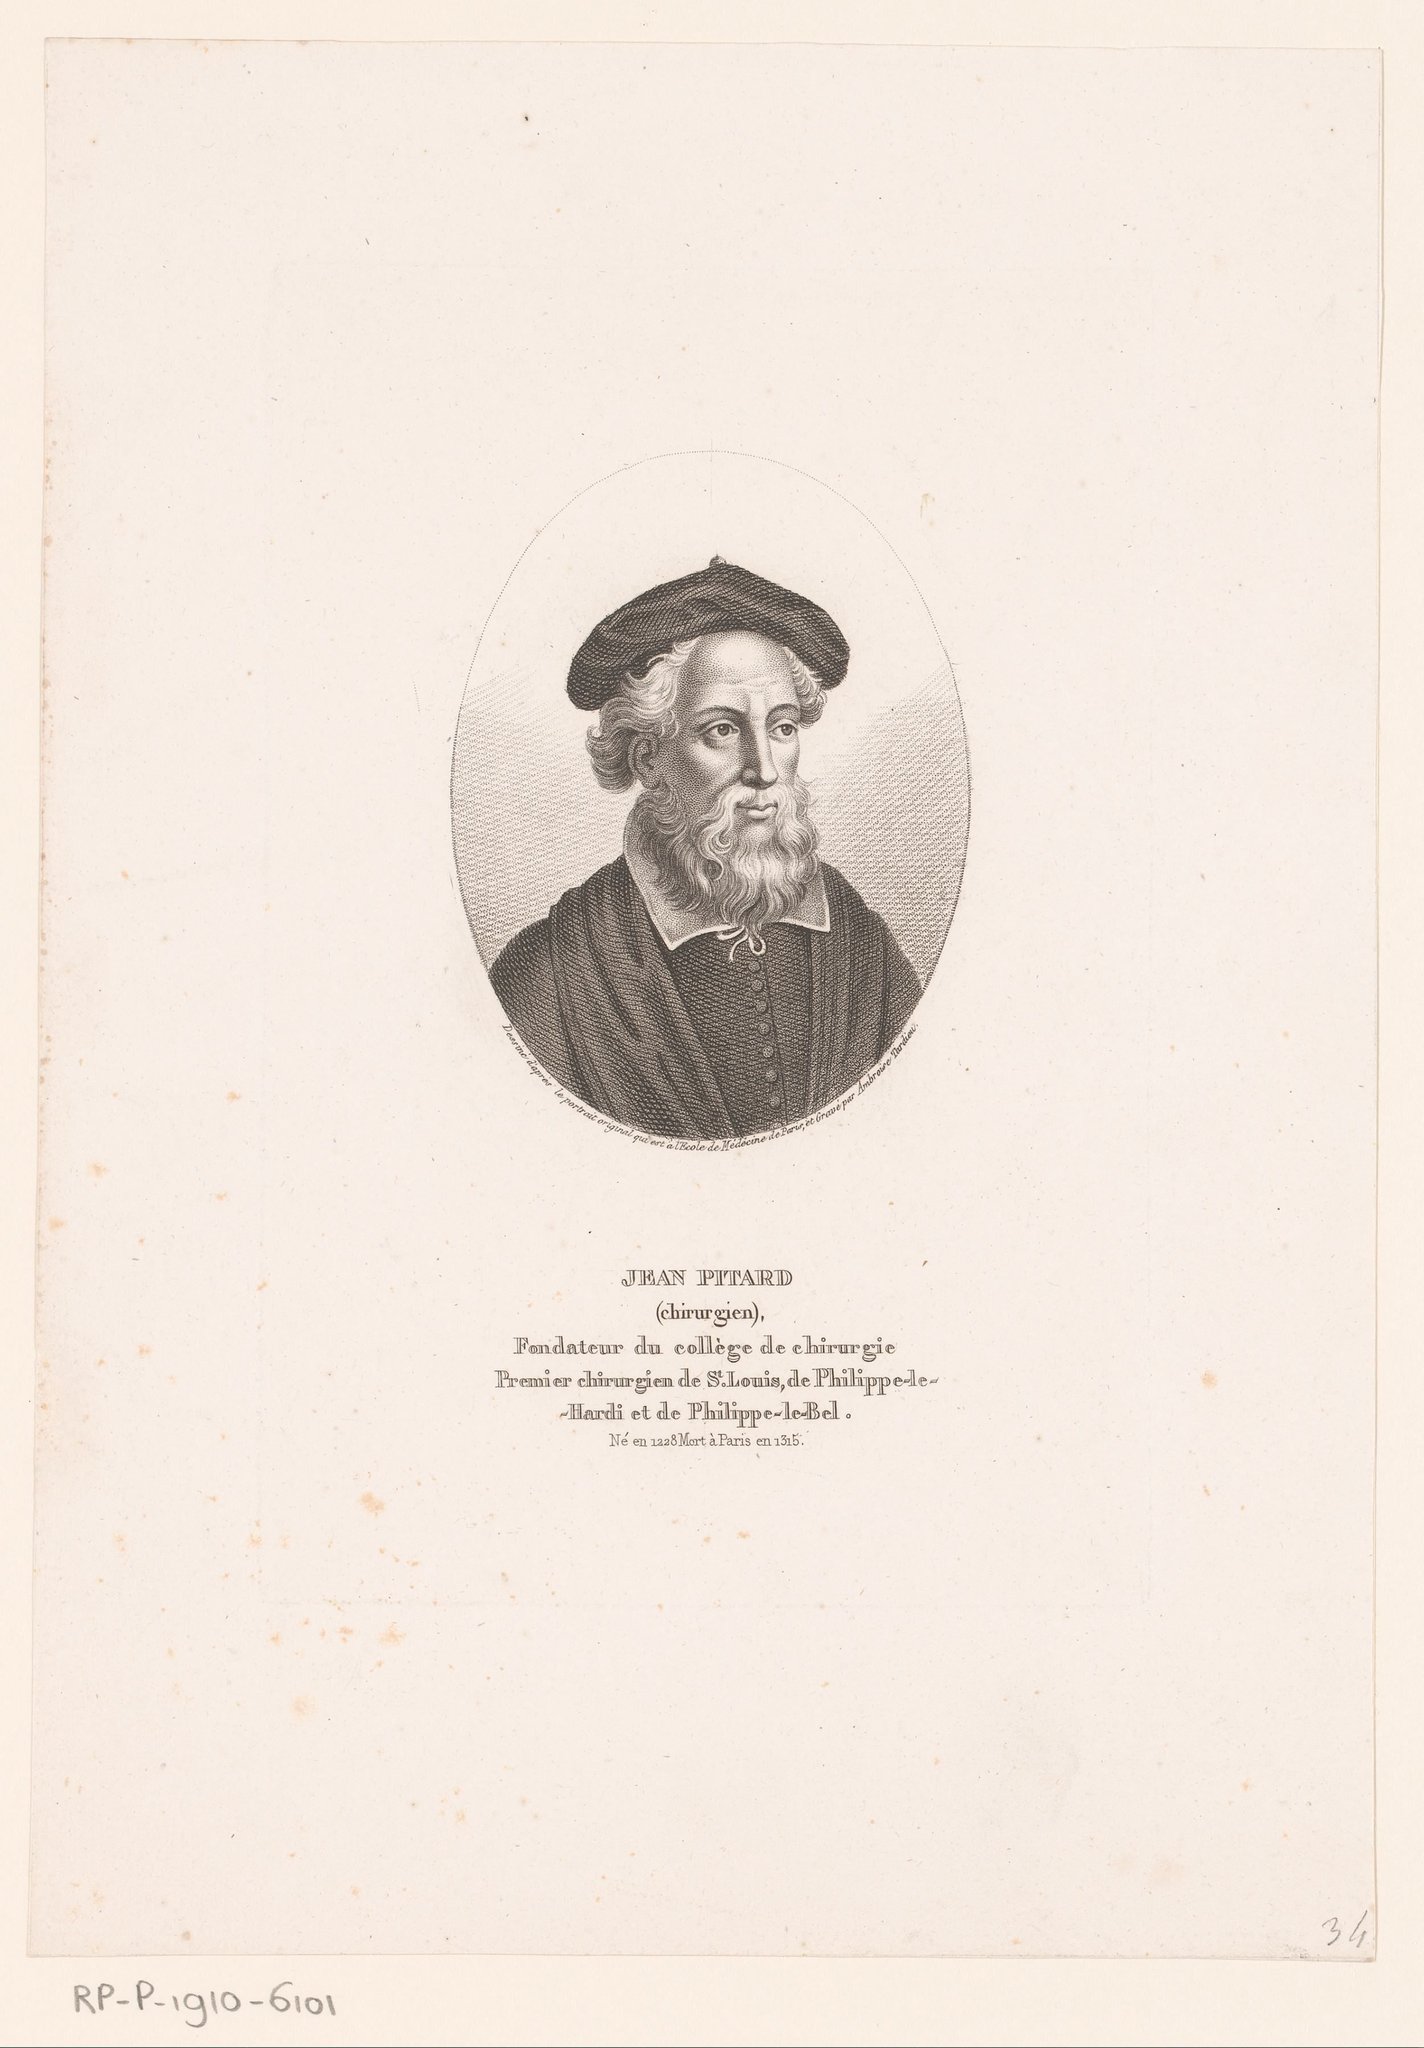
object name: print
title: Collection de tous les personnages célèbres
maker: ambroise tardieu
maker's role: print maker, printer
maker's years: 1788-1841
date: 1820-1828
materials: paper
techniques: engraving, roulette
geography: paris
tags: paris, historical persons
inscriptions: collector's mark: Lugt 2228